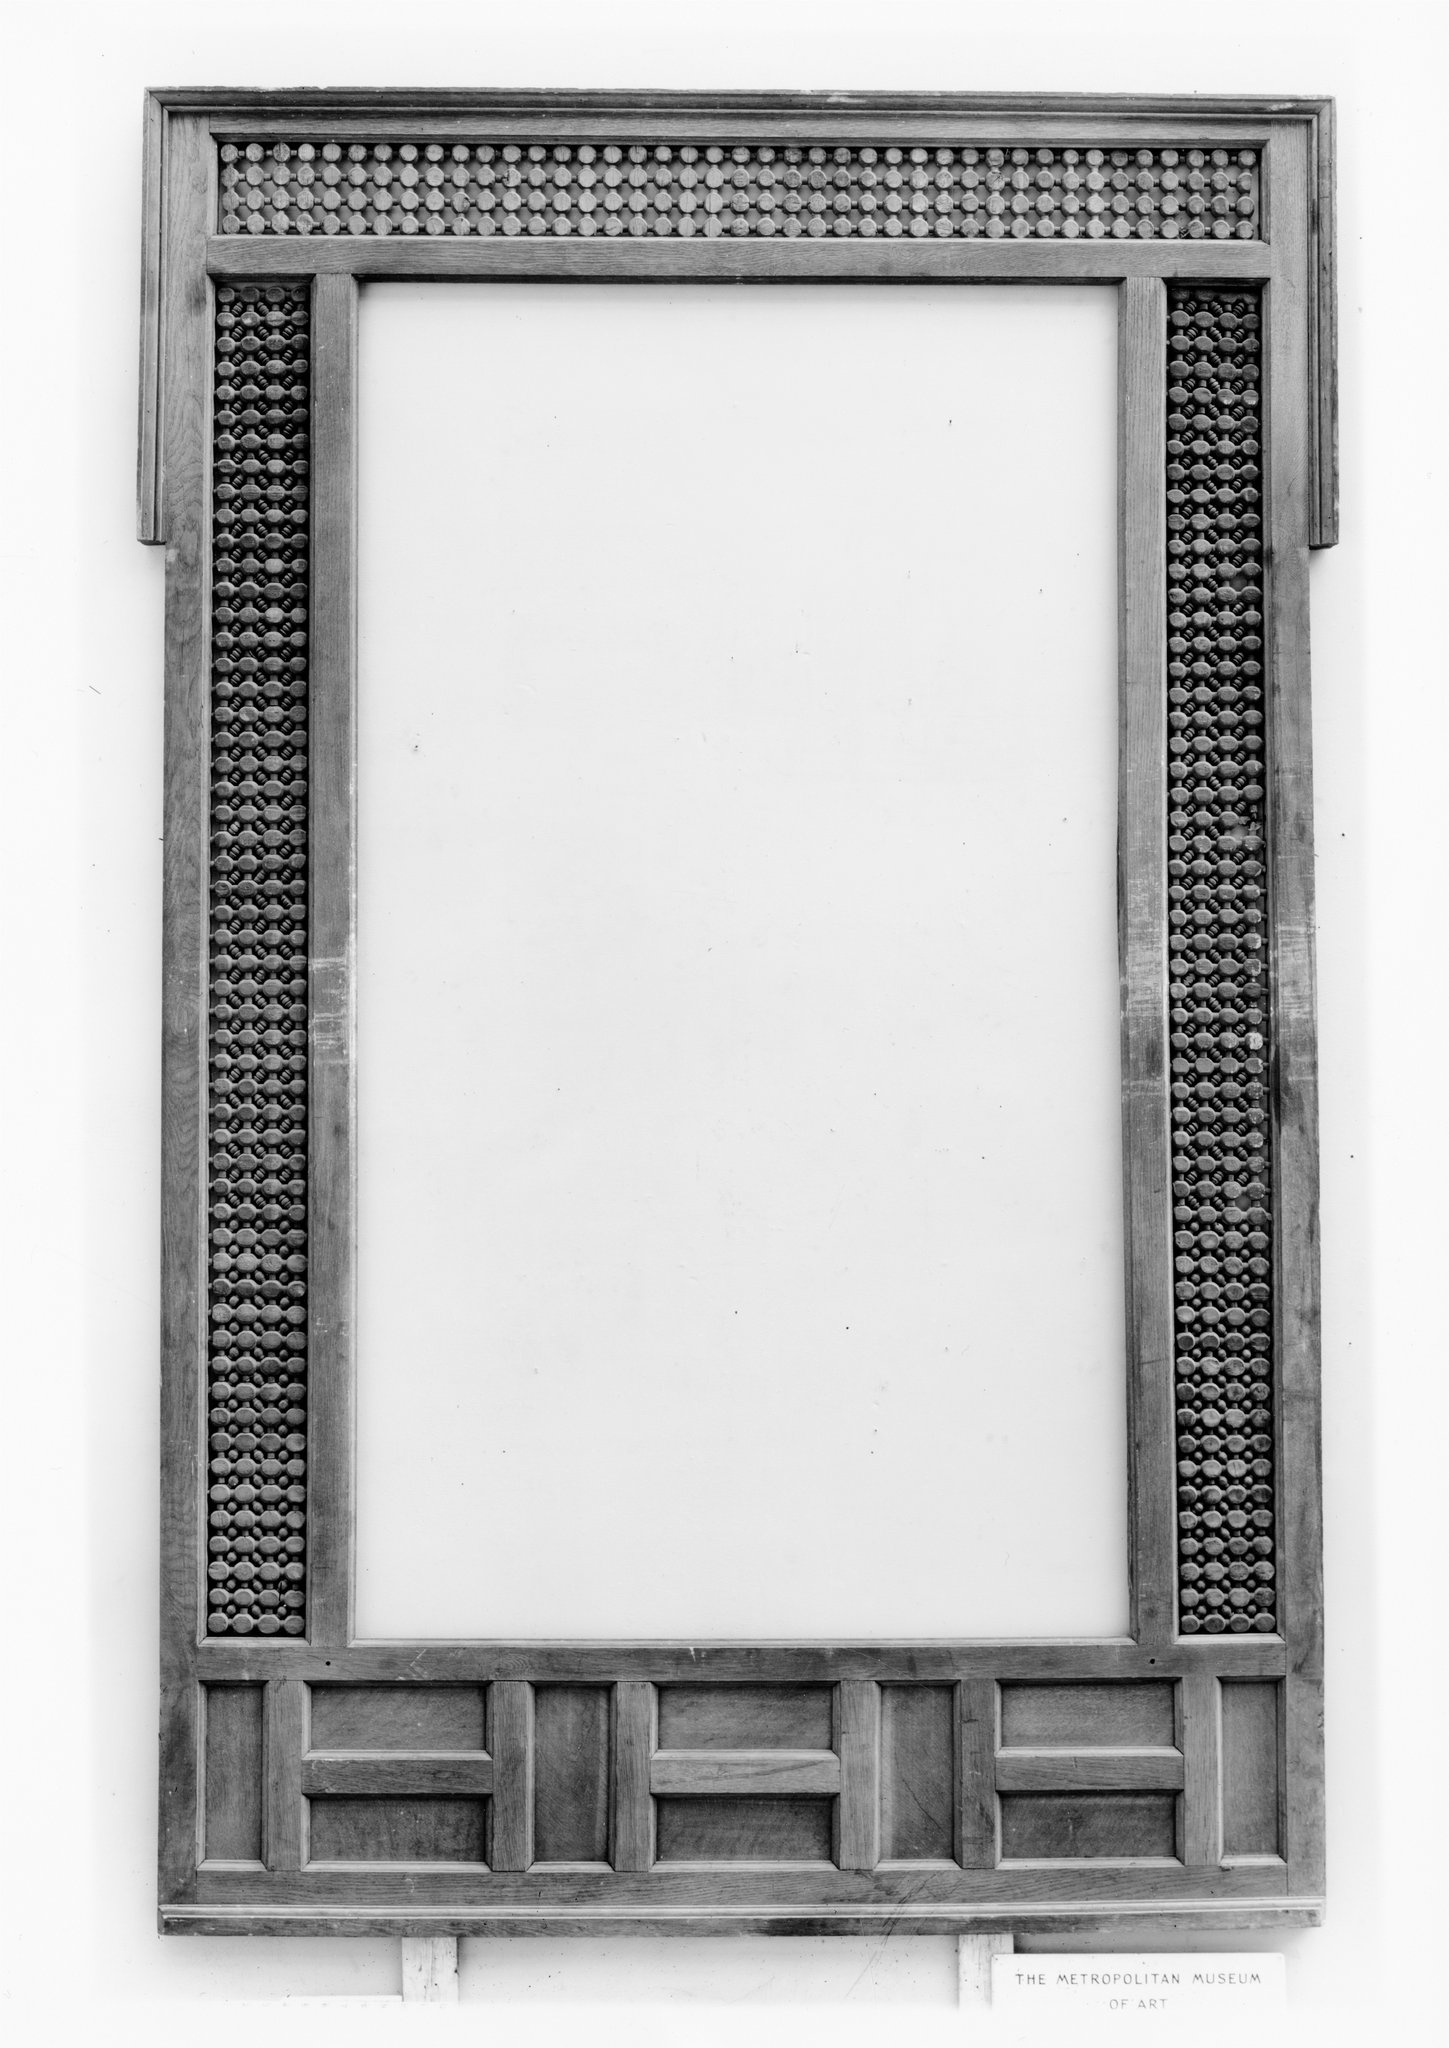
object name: screen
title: Mashrabiyya Screen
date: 1401-1600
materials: wood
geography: egypt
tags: screens